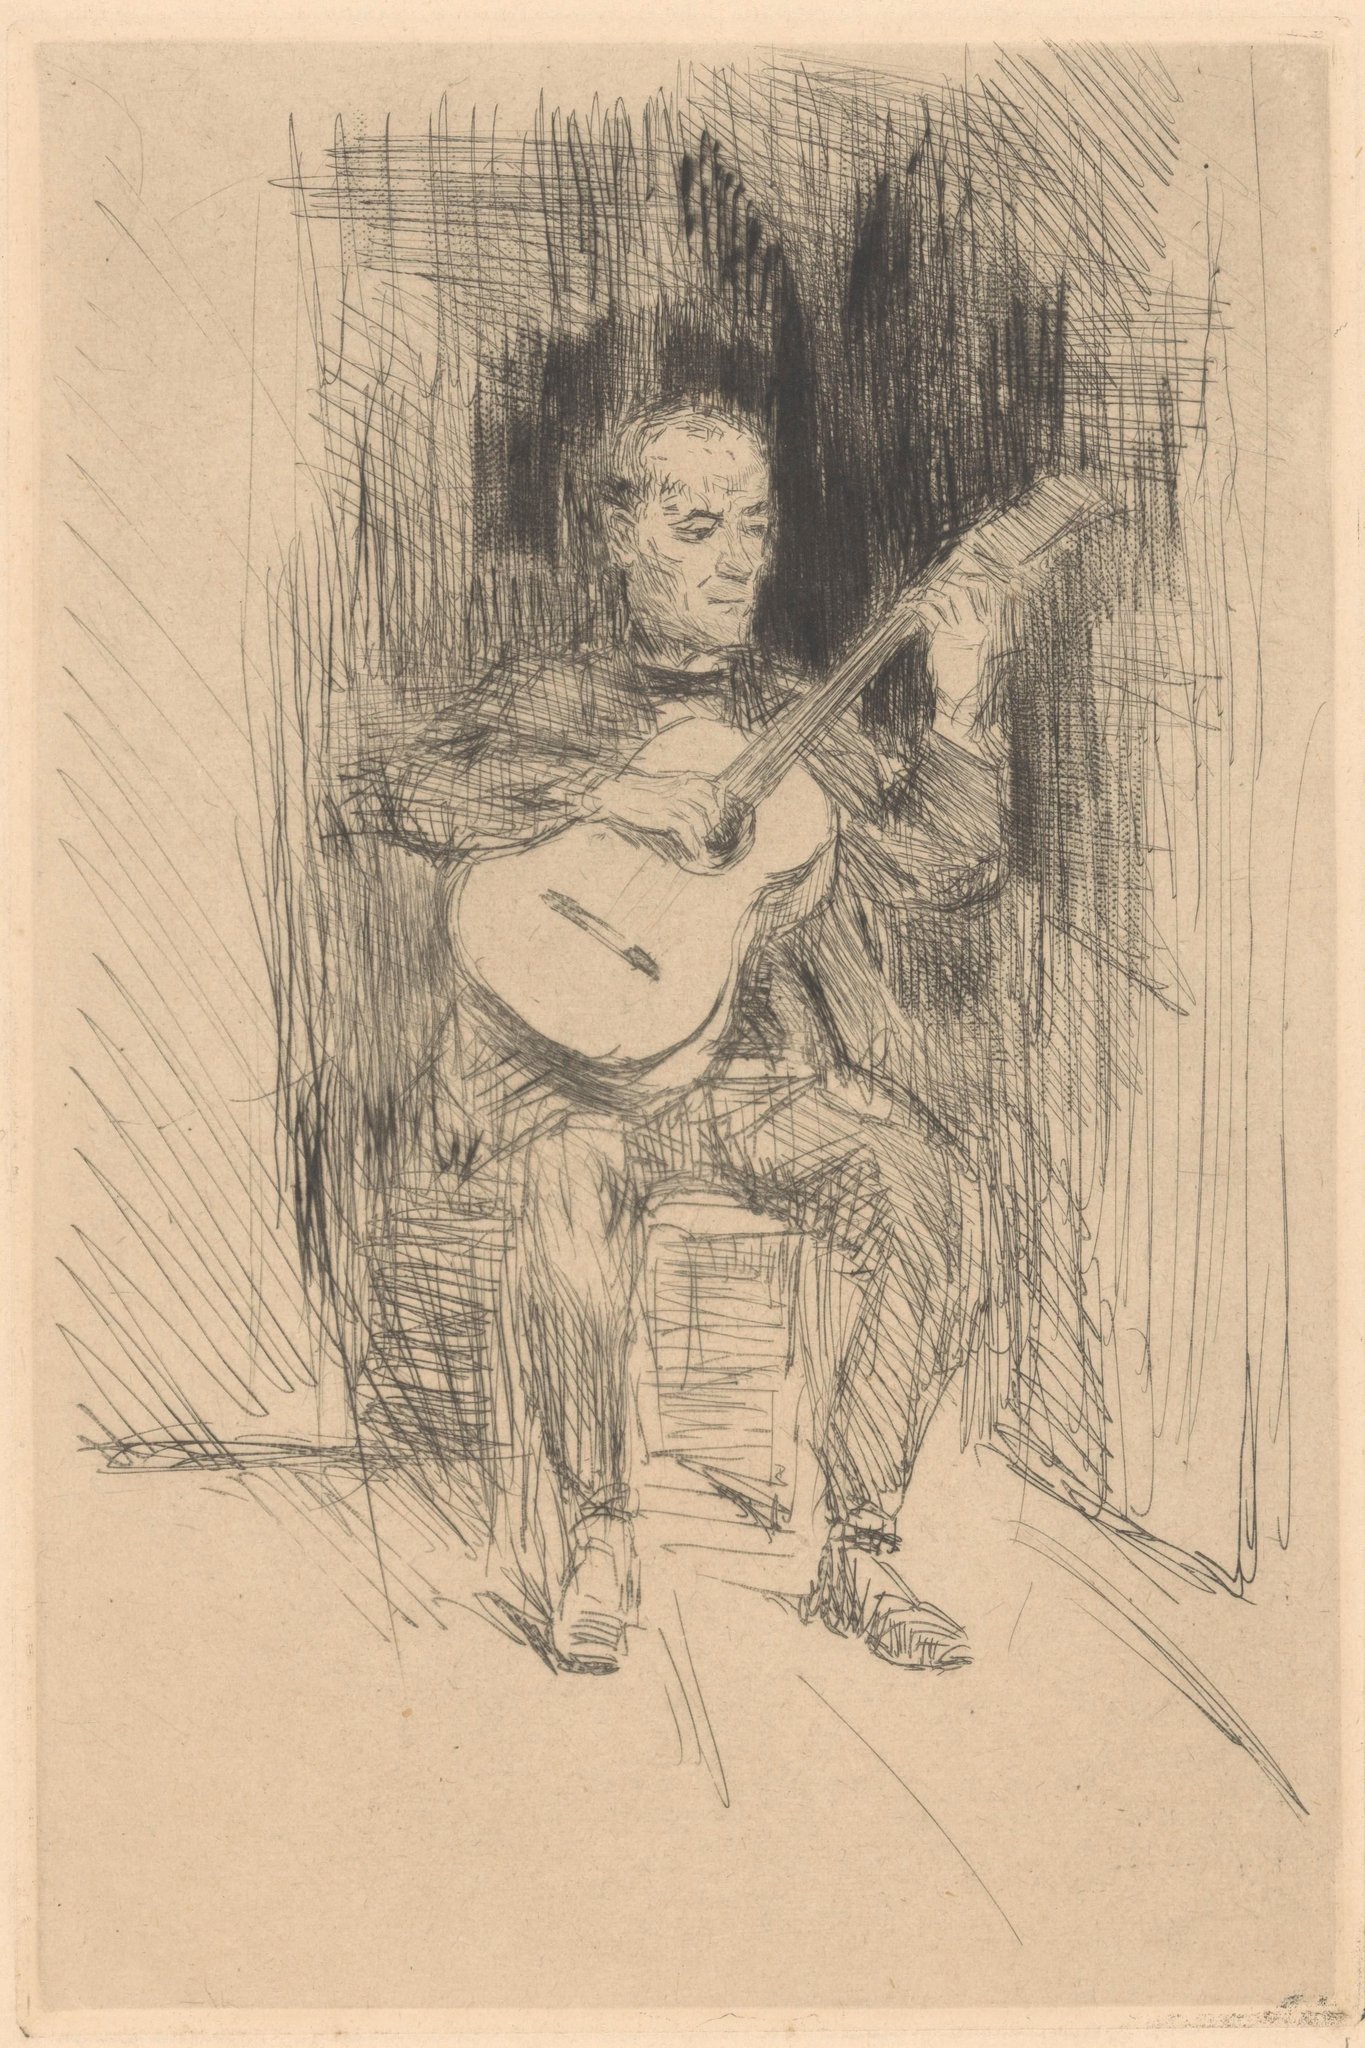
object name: print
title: Zittende gitaarspeler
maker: isaac israels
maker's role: draughtsman, painter, print maker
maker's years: 1865-1934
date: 1878-1934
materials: paper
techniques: etching, roulette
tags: one person playing an instrument, cithern, mandolin, guitar, balalaika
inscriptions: collector's mark: Lugt 2228, number: ‘4820’